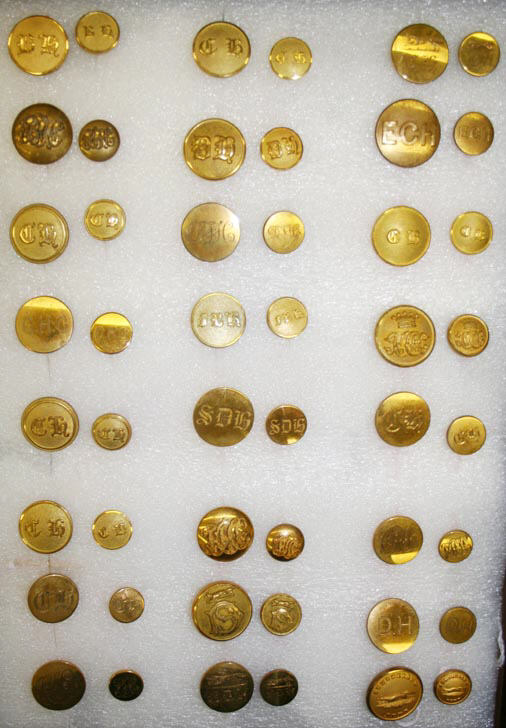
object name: button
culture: british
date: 1850-1880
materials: metal